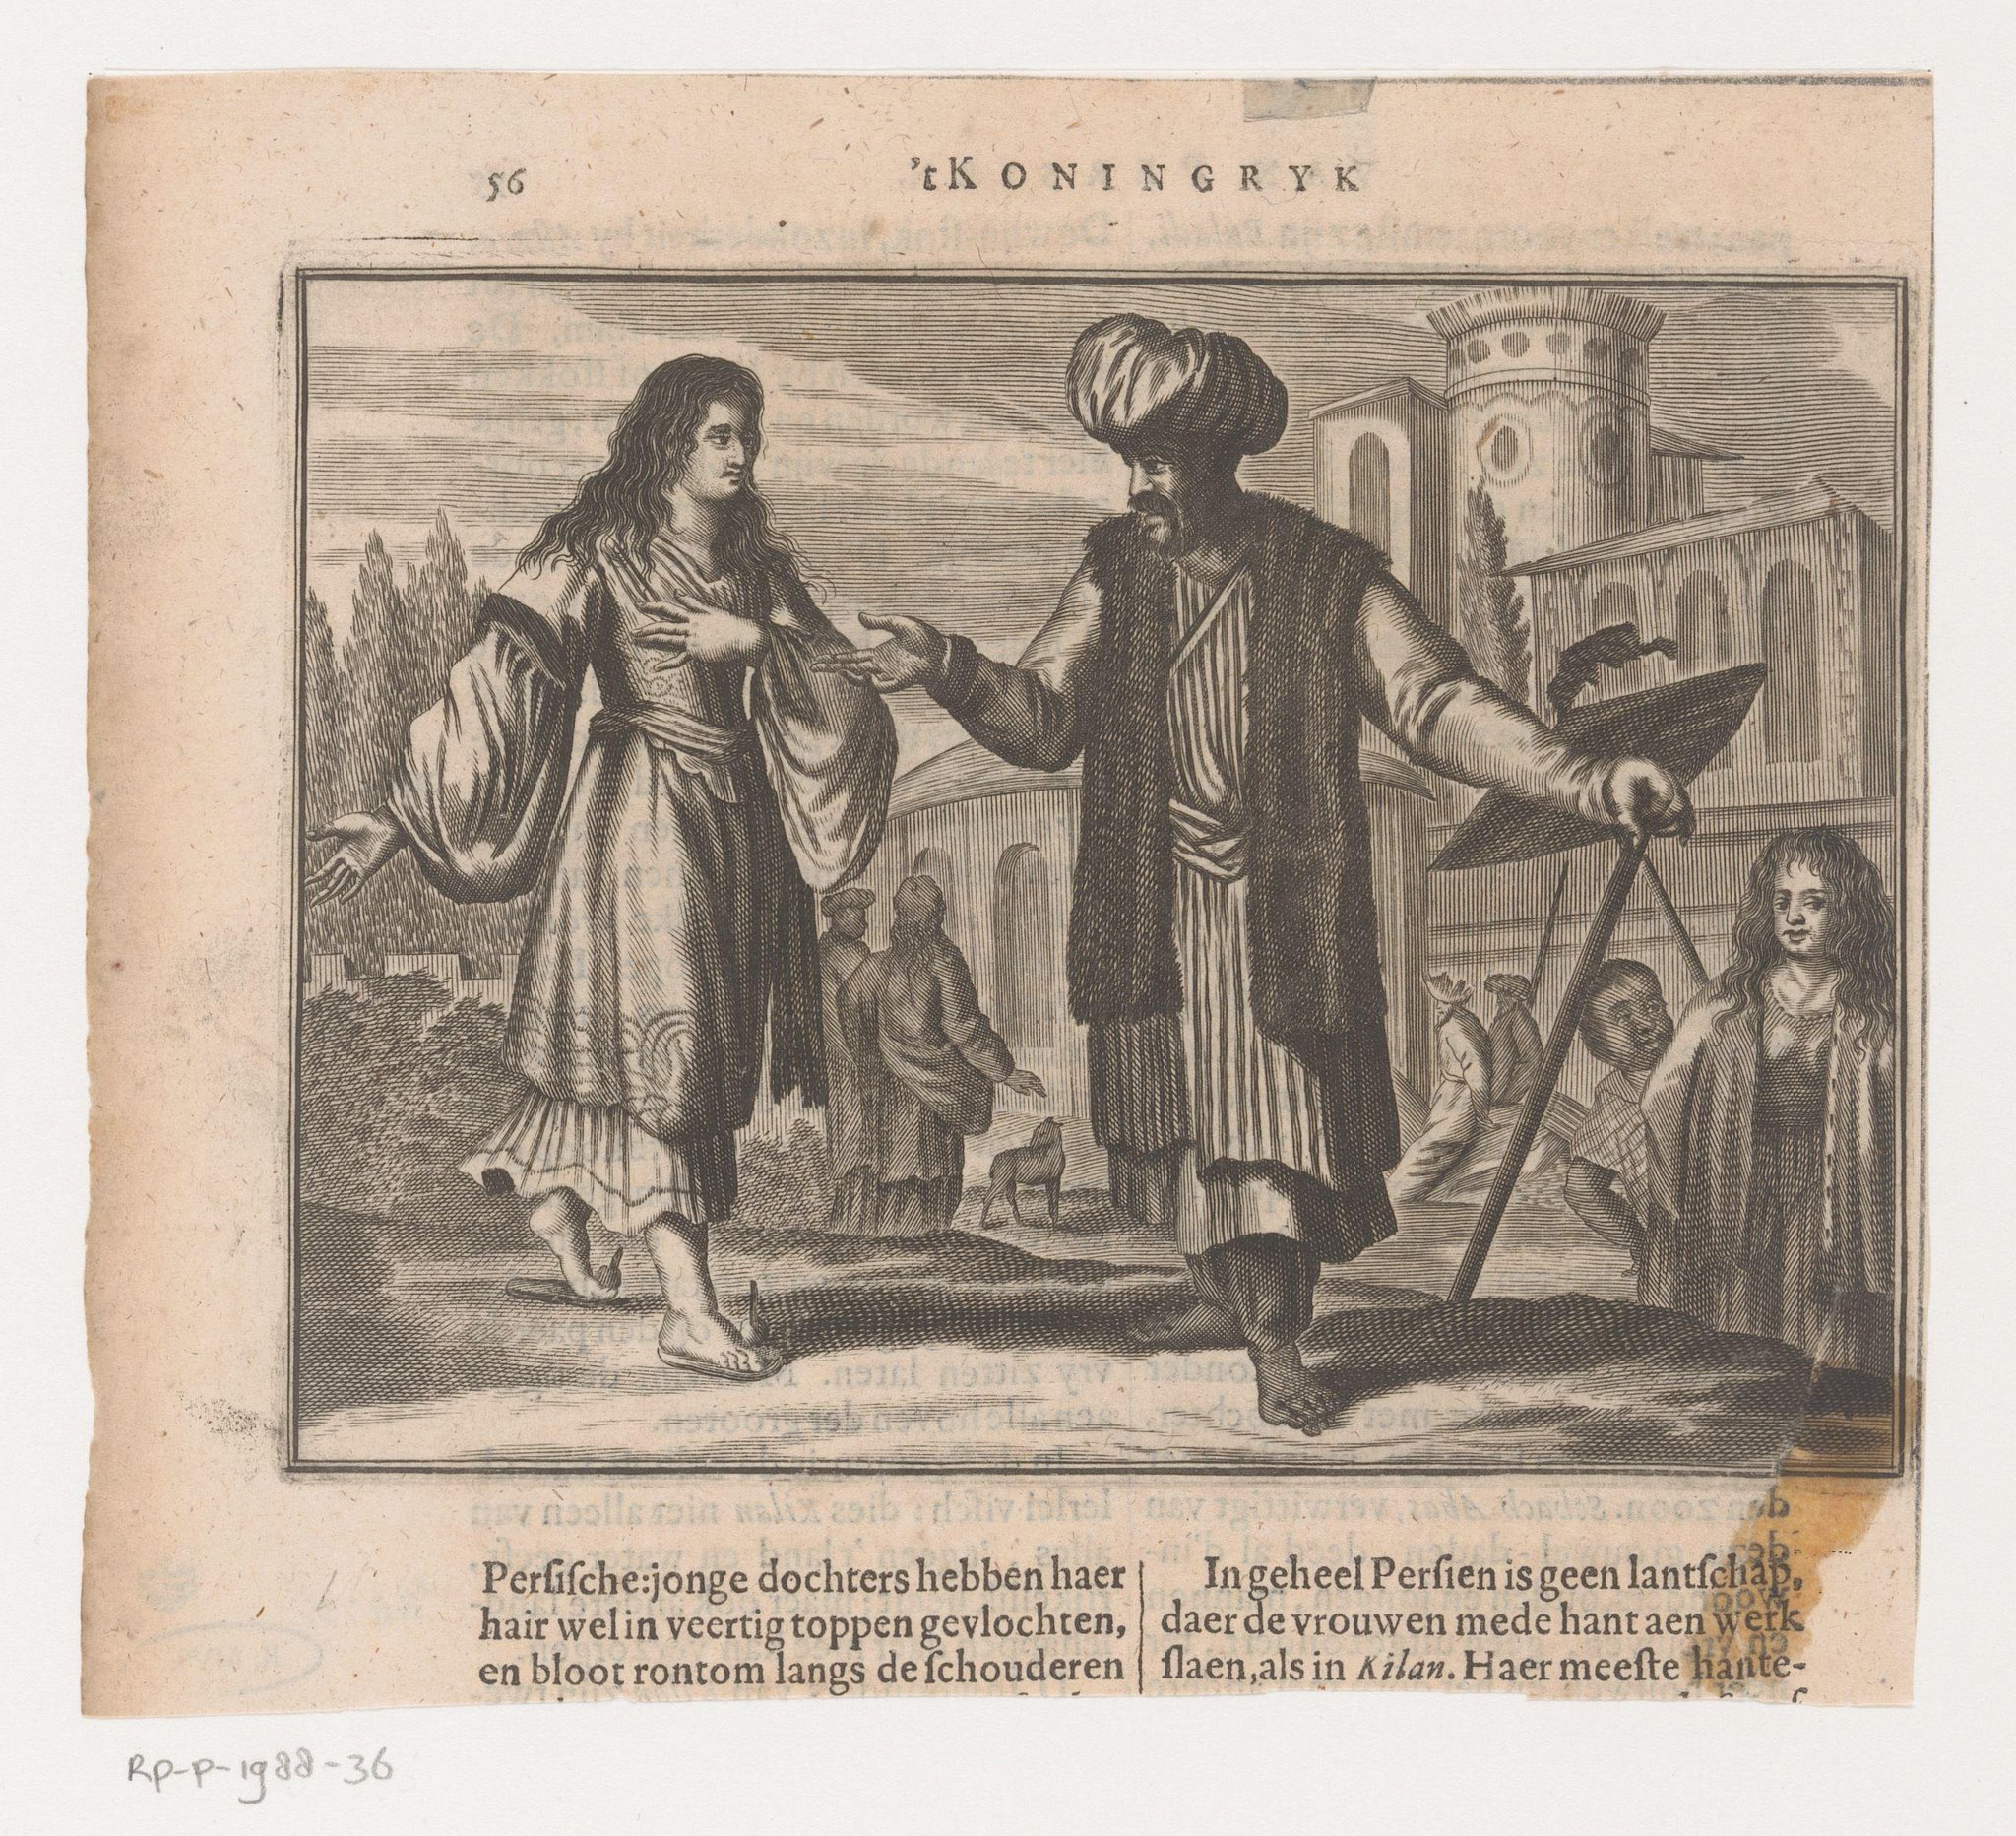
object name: book illustration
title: Kostuums in de Perzische provincie Kilan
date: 1672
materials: paper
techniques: engraving, letterpress printing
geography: amsterdam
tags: asiatic races and peoples, persia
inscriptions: collector's mark: Lugt 2760, collector's mark: Lugt 2228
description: Prent uit: Dapper, Olfert. Beschrijving des koningrycks van Persie, behelsende de landschappen Fars, Schirwan, Erak, Adirbeitzan, Karabach (...). Amsterdam: Jacob van Meurs, 1672, p. 56.